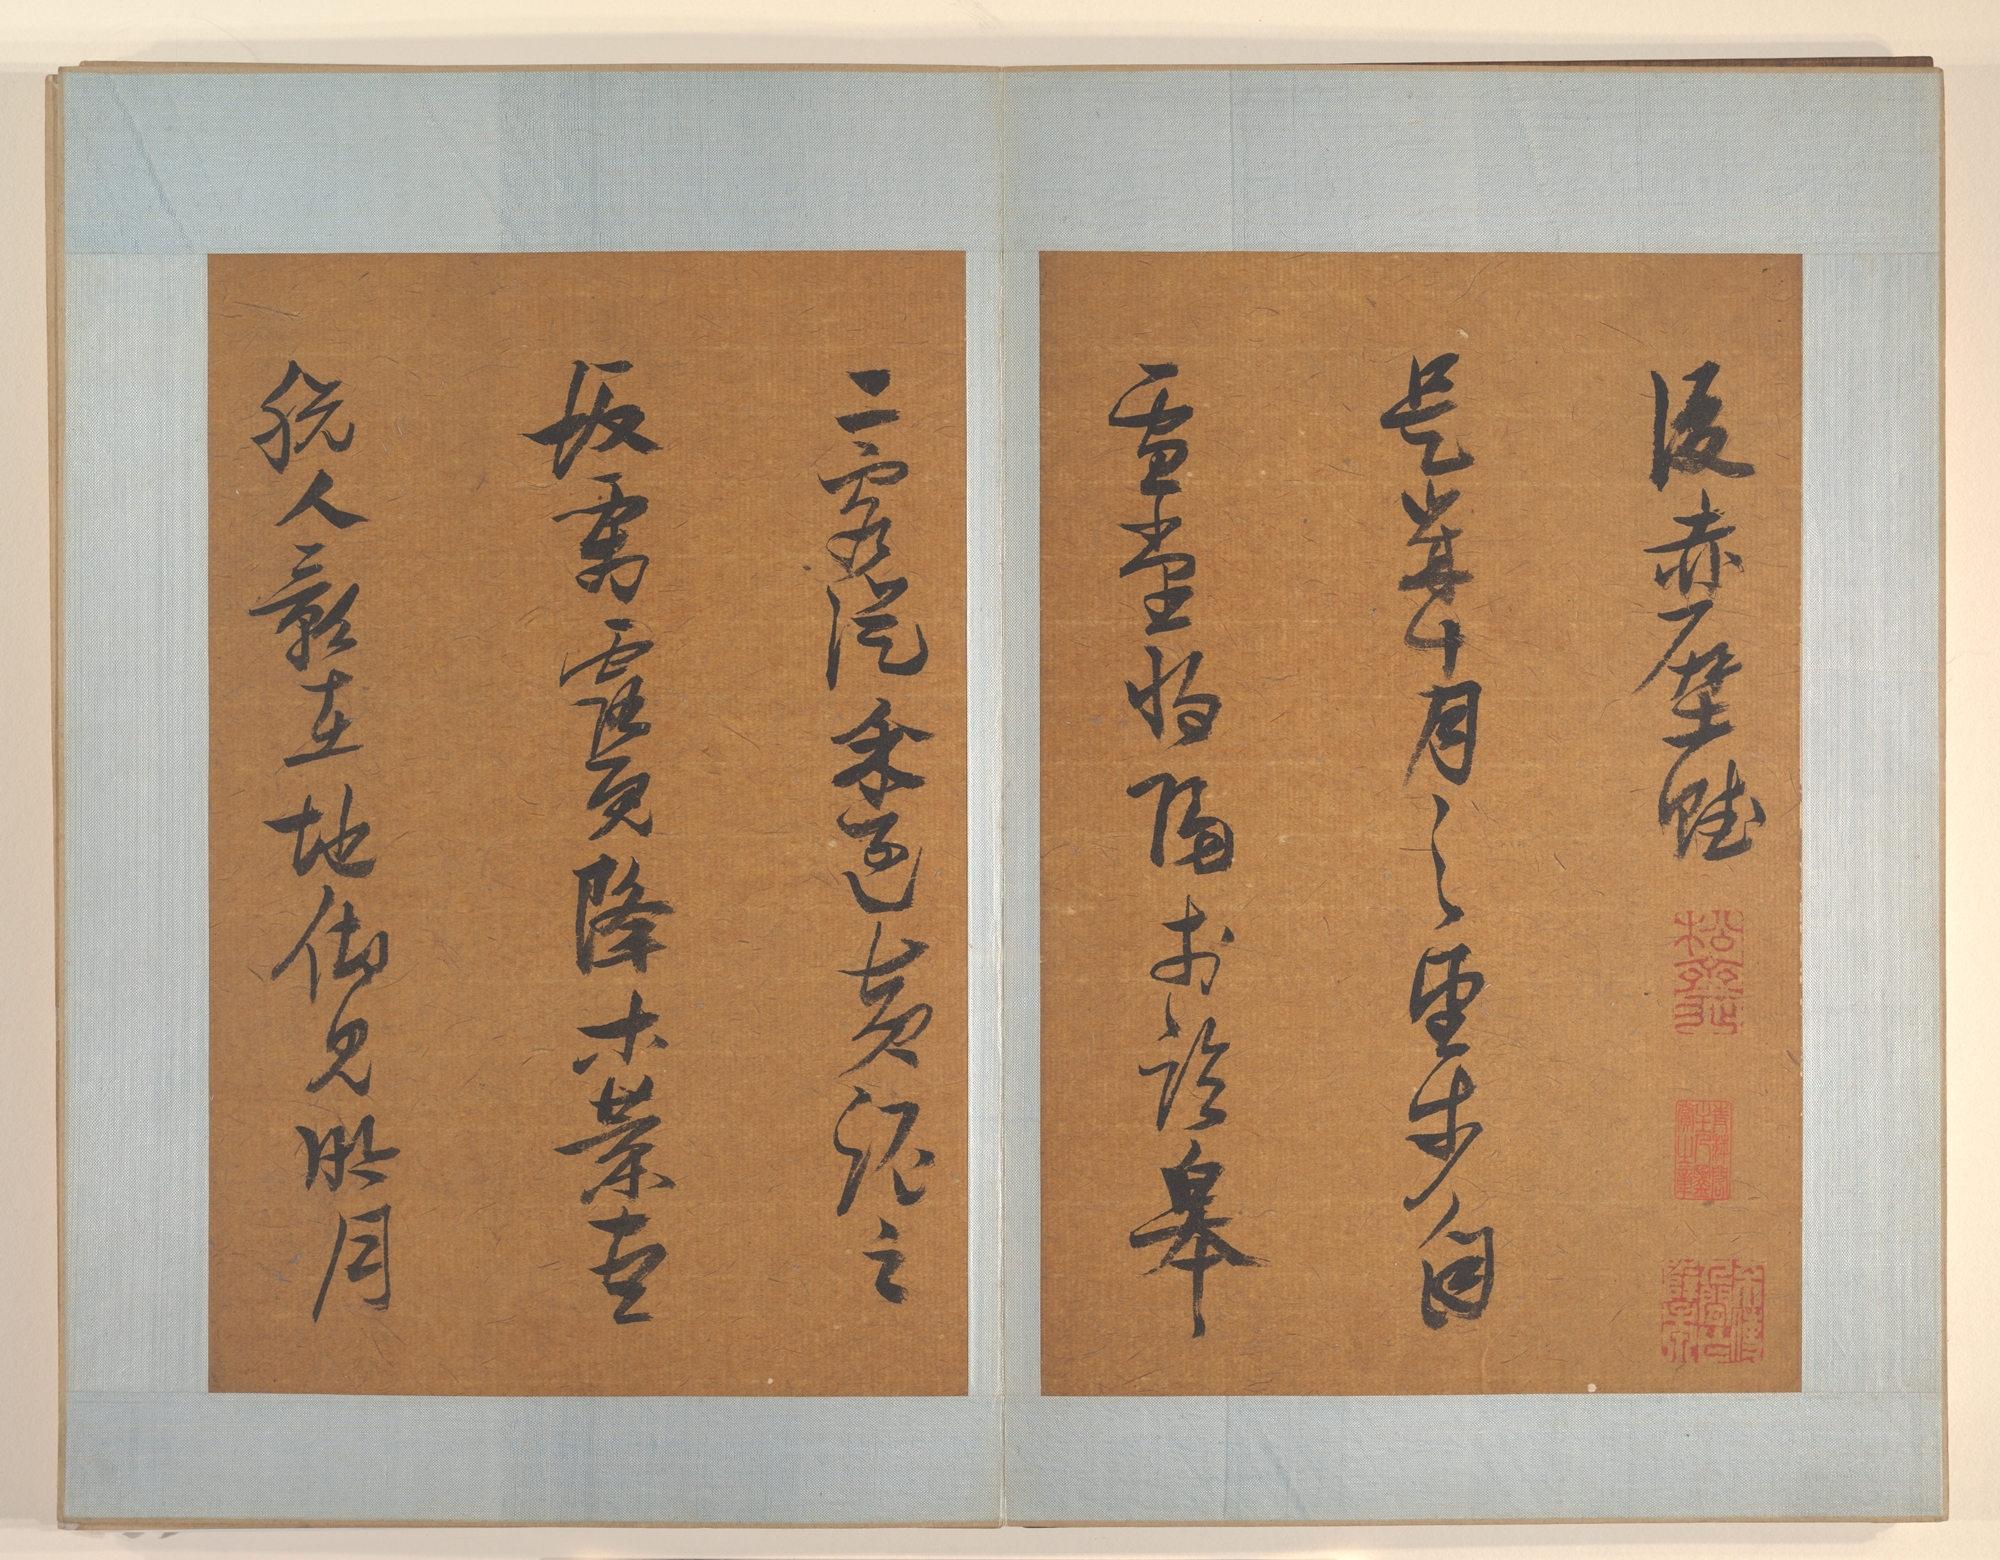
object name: album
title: The Red Cliff Ode, by Su Dongpo (1036-1101)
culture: chinese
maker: zhang ruitu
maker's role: artist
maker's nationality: chinese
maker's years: 1570-1641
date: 1601-1700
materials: ink, paper